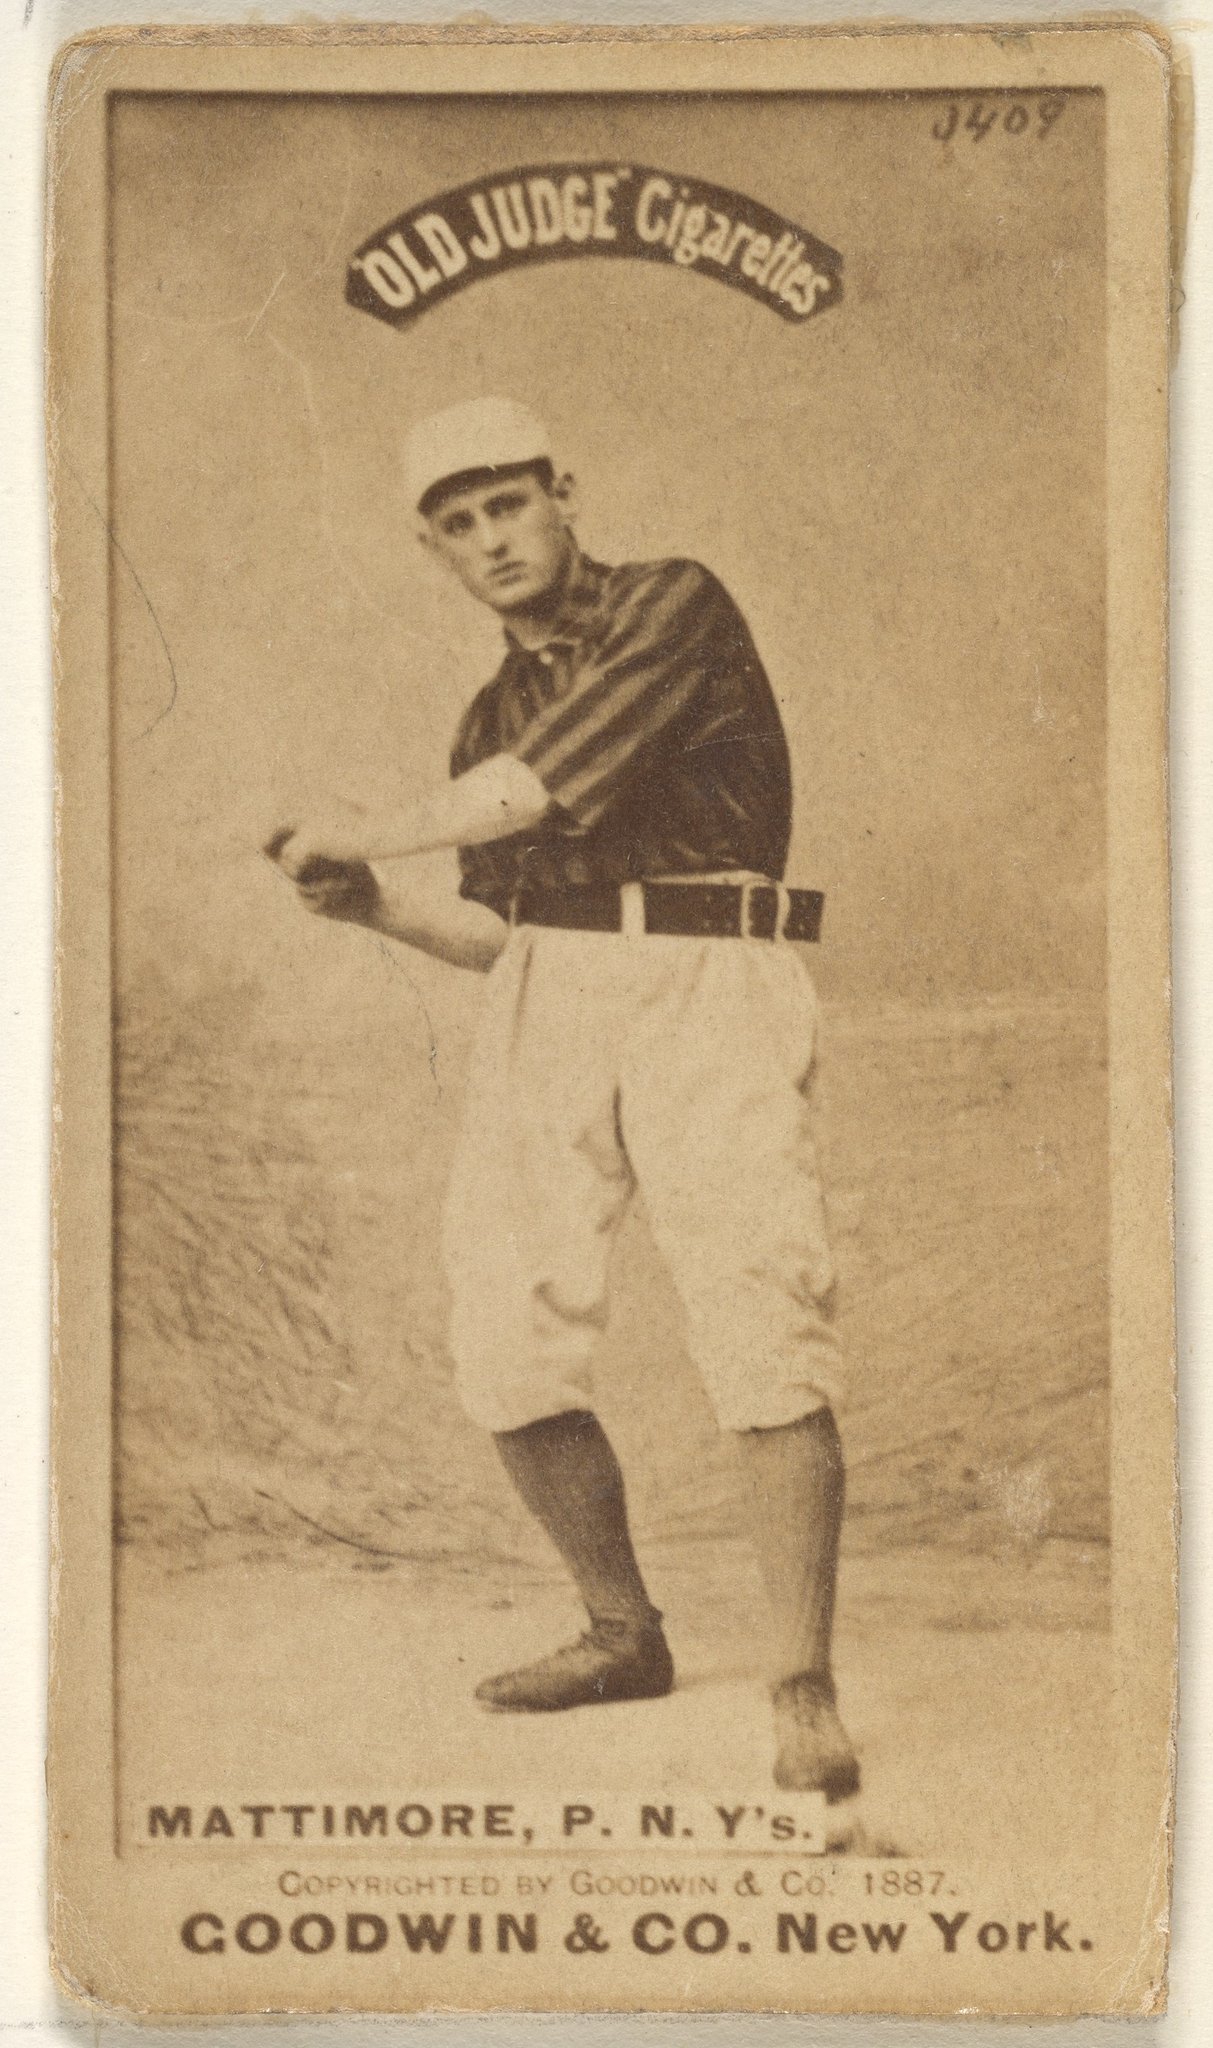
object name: baseball card, photograph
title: Michael "Mike" Joseph Mattimore, Pitcher, New York, from the Old Judge series (N172) for Old Judge Cigarettes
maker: goodwin & company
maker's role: publisher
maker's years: 1850-1950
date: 1887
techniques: albumen silver print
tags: men,portraits,baseball,athletes